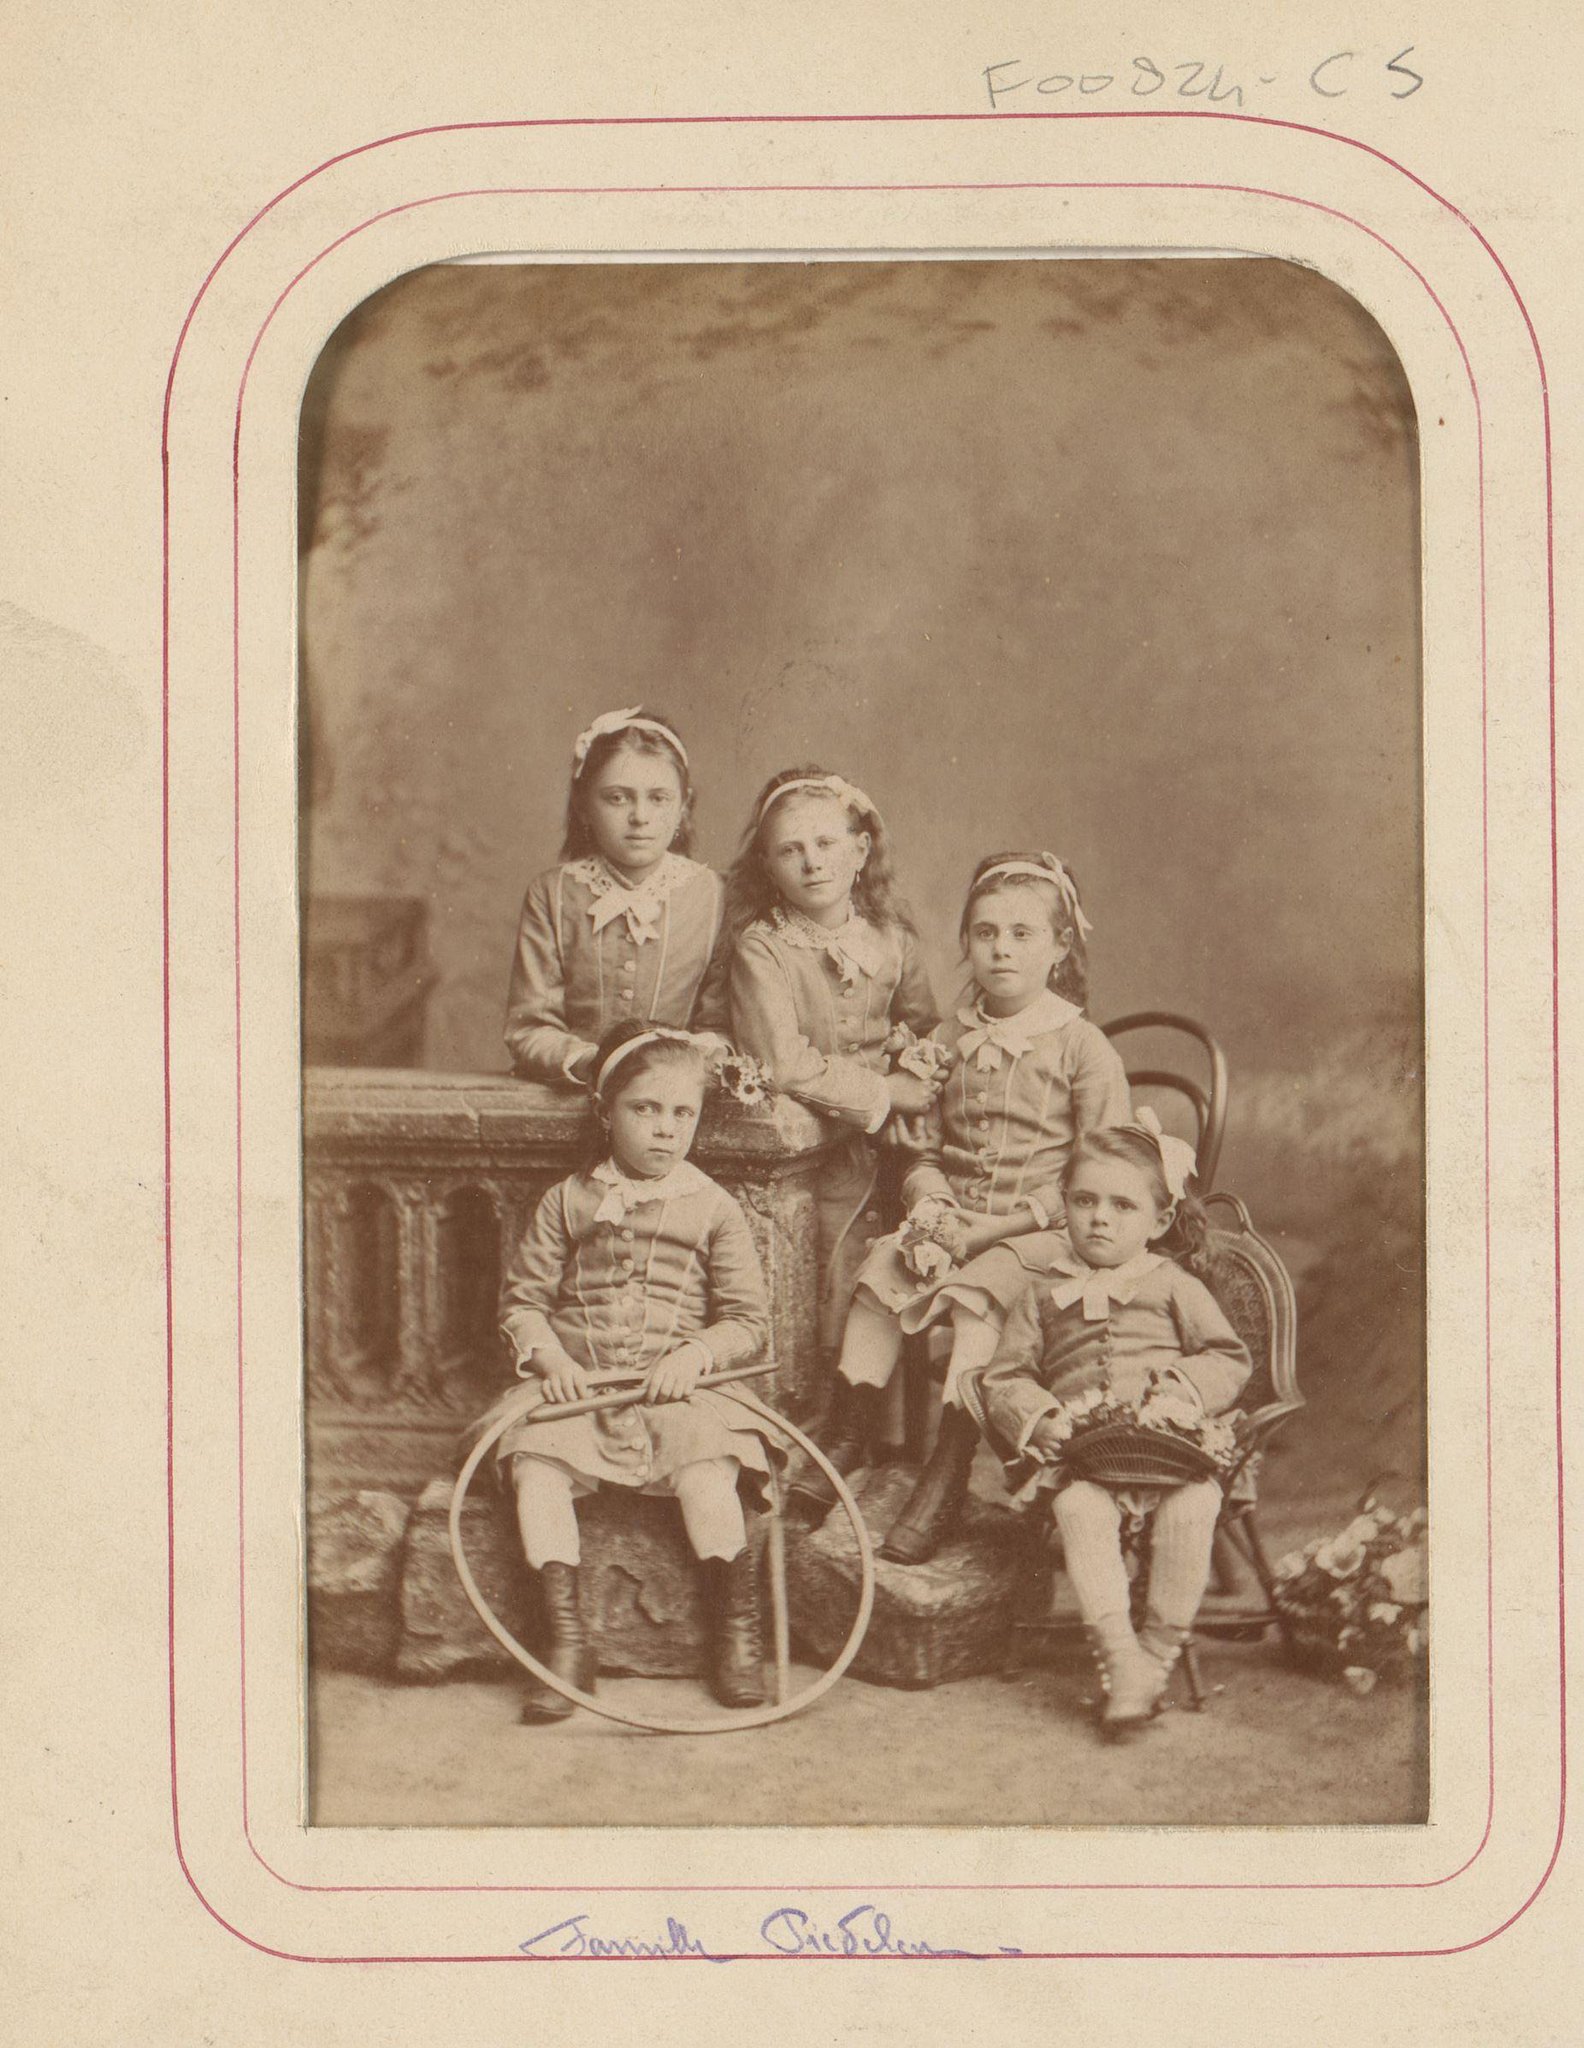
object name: photograph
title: Groepsportret van de familie Piedelen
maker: jean-marie pipaud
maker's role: fotograaf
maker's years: 1847-1924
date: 1886-1895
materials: cardboard, paper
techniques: albumen print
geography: nantes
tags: sisters (second degree family relationships), anonymous historical persons portrayed in a group, in a group-portrait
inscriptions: address: ‘11, Rue Crébillon/ NANTES’